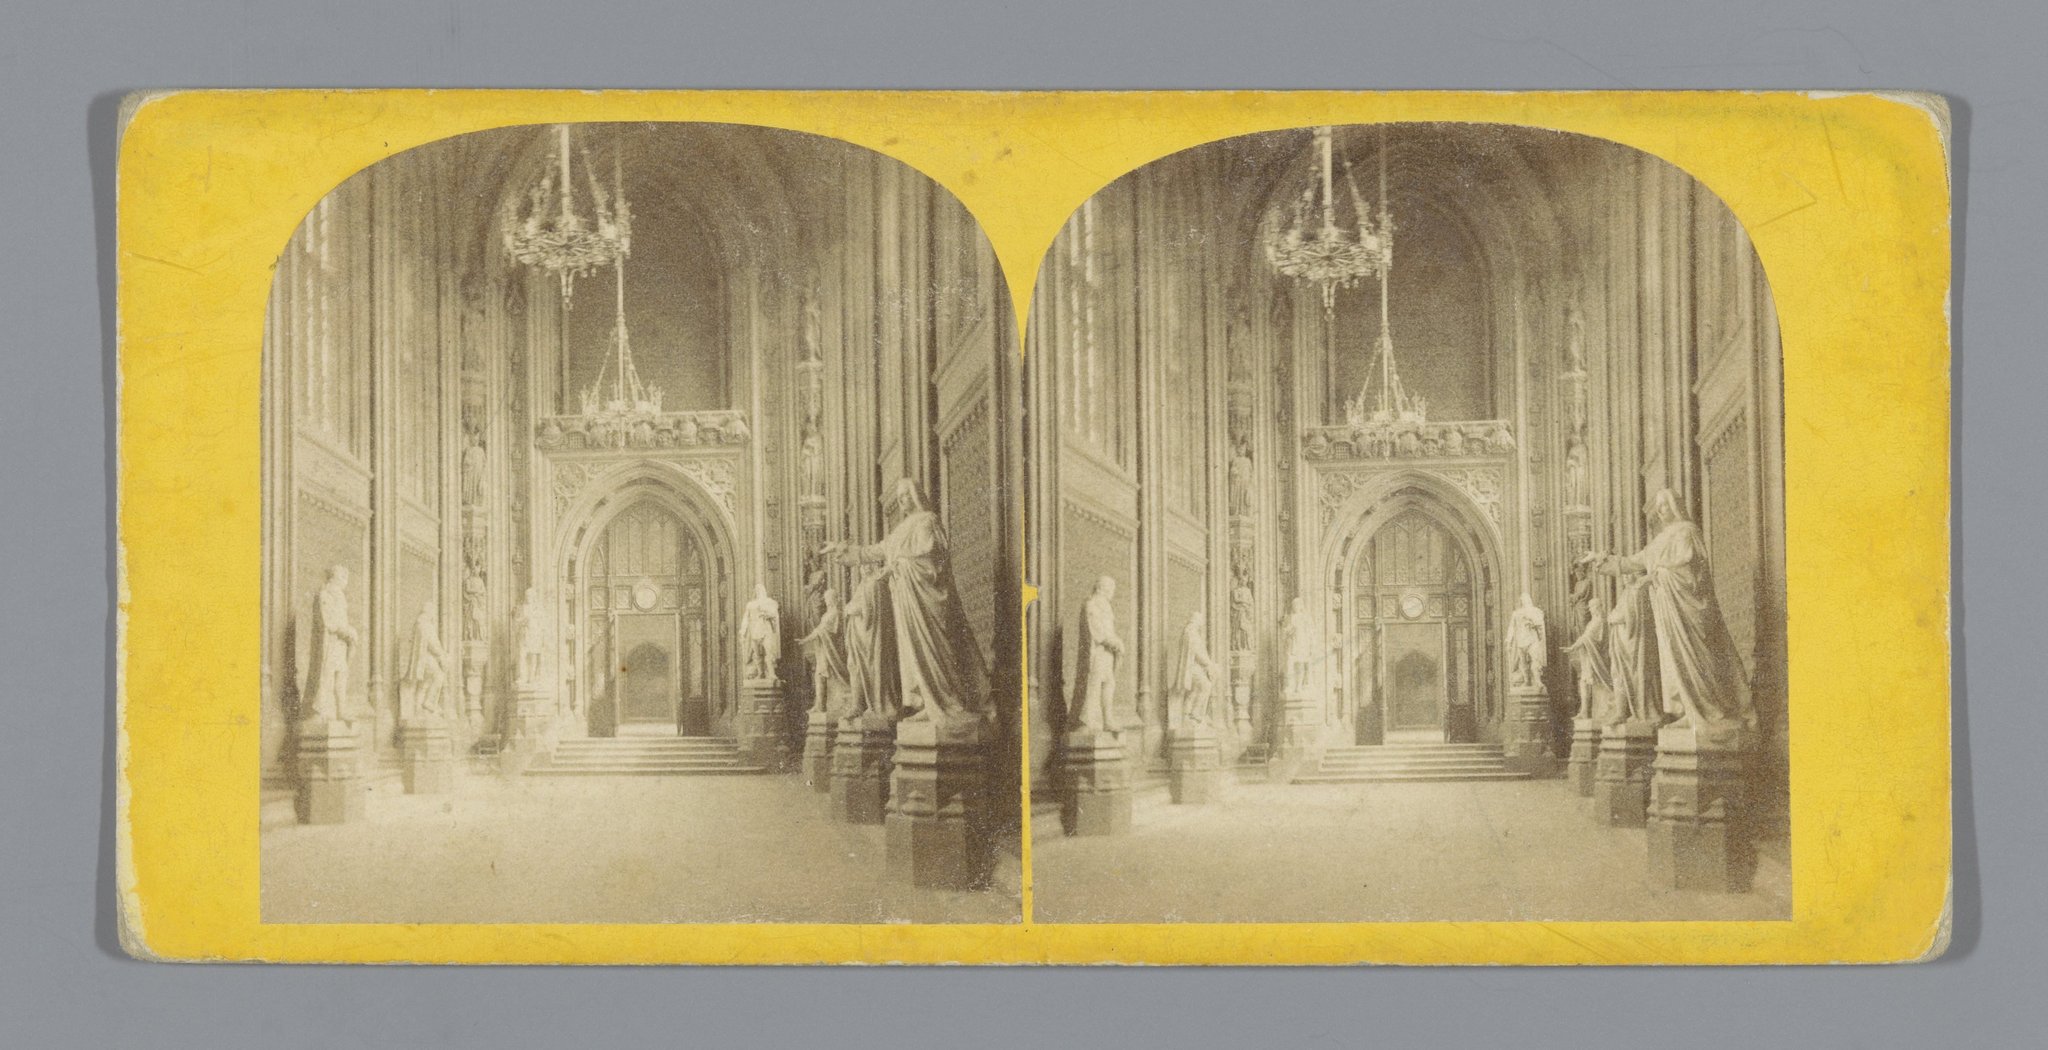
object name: stereograph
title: St. Stephen's Hall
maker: Anonymous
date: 1850-1880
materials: cardboard, photographic support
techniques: albumen print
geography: houses of parliament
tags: chapel (interior of the house)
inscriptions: number: ‘122’, name, inscription: ‘(Photographed by special permission.)’